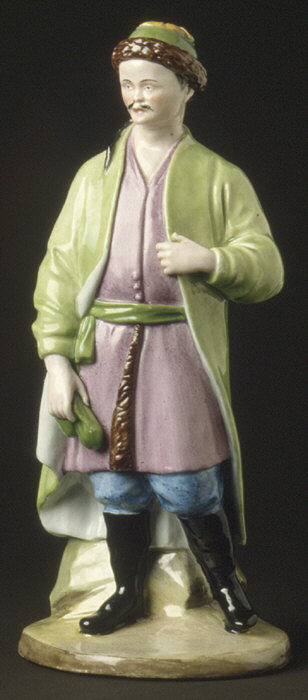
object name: figure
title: Kalmuk Man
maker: imperial porcelain manufactory, st. petersburg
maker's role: manufactory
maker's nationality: russian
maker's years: 1744-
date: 1780-1800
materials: hard paste porcelain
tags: men